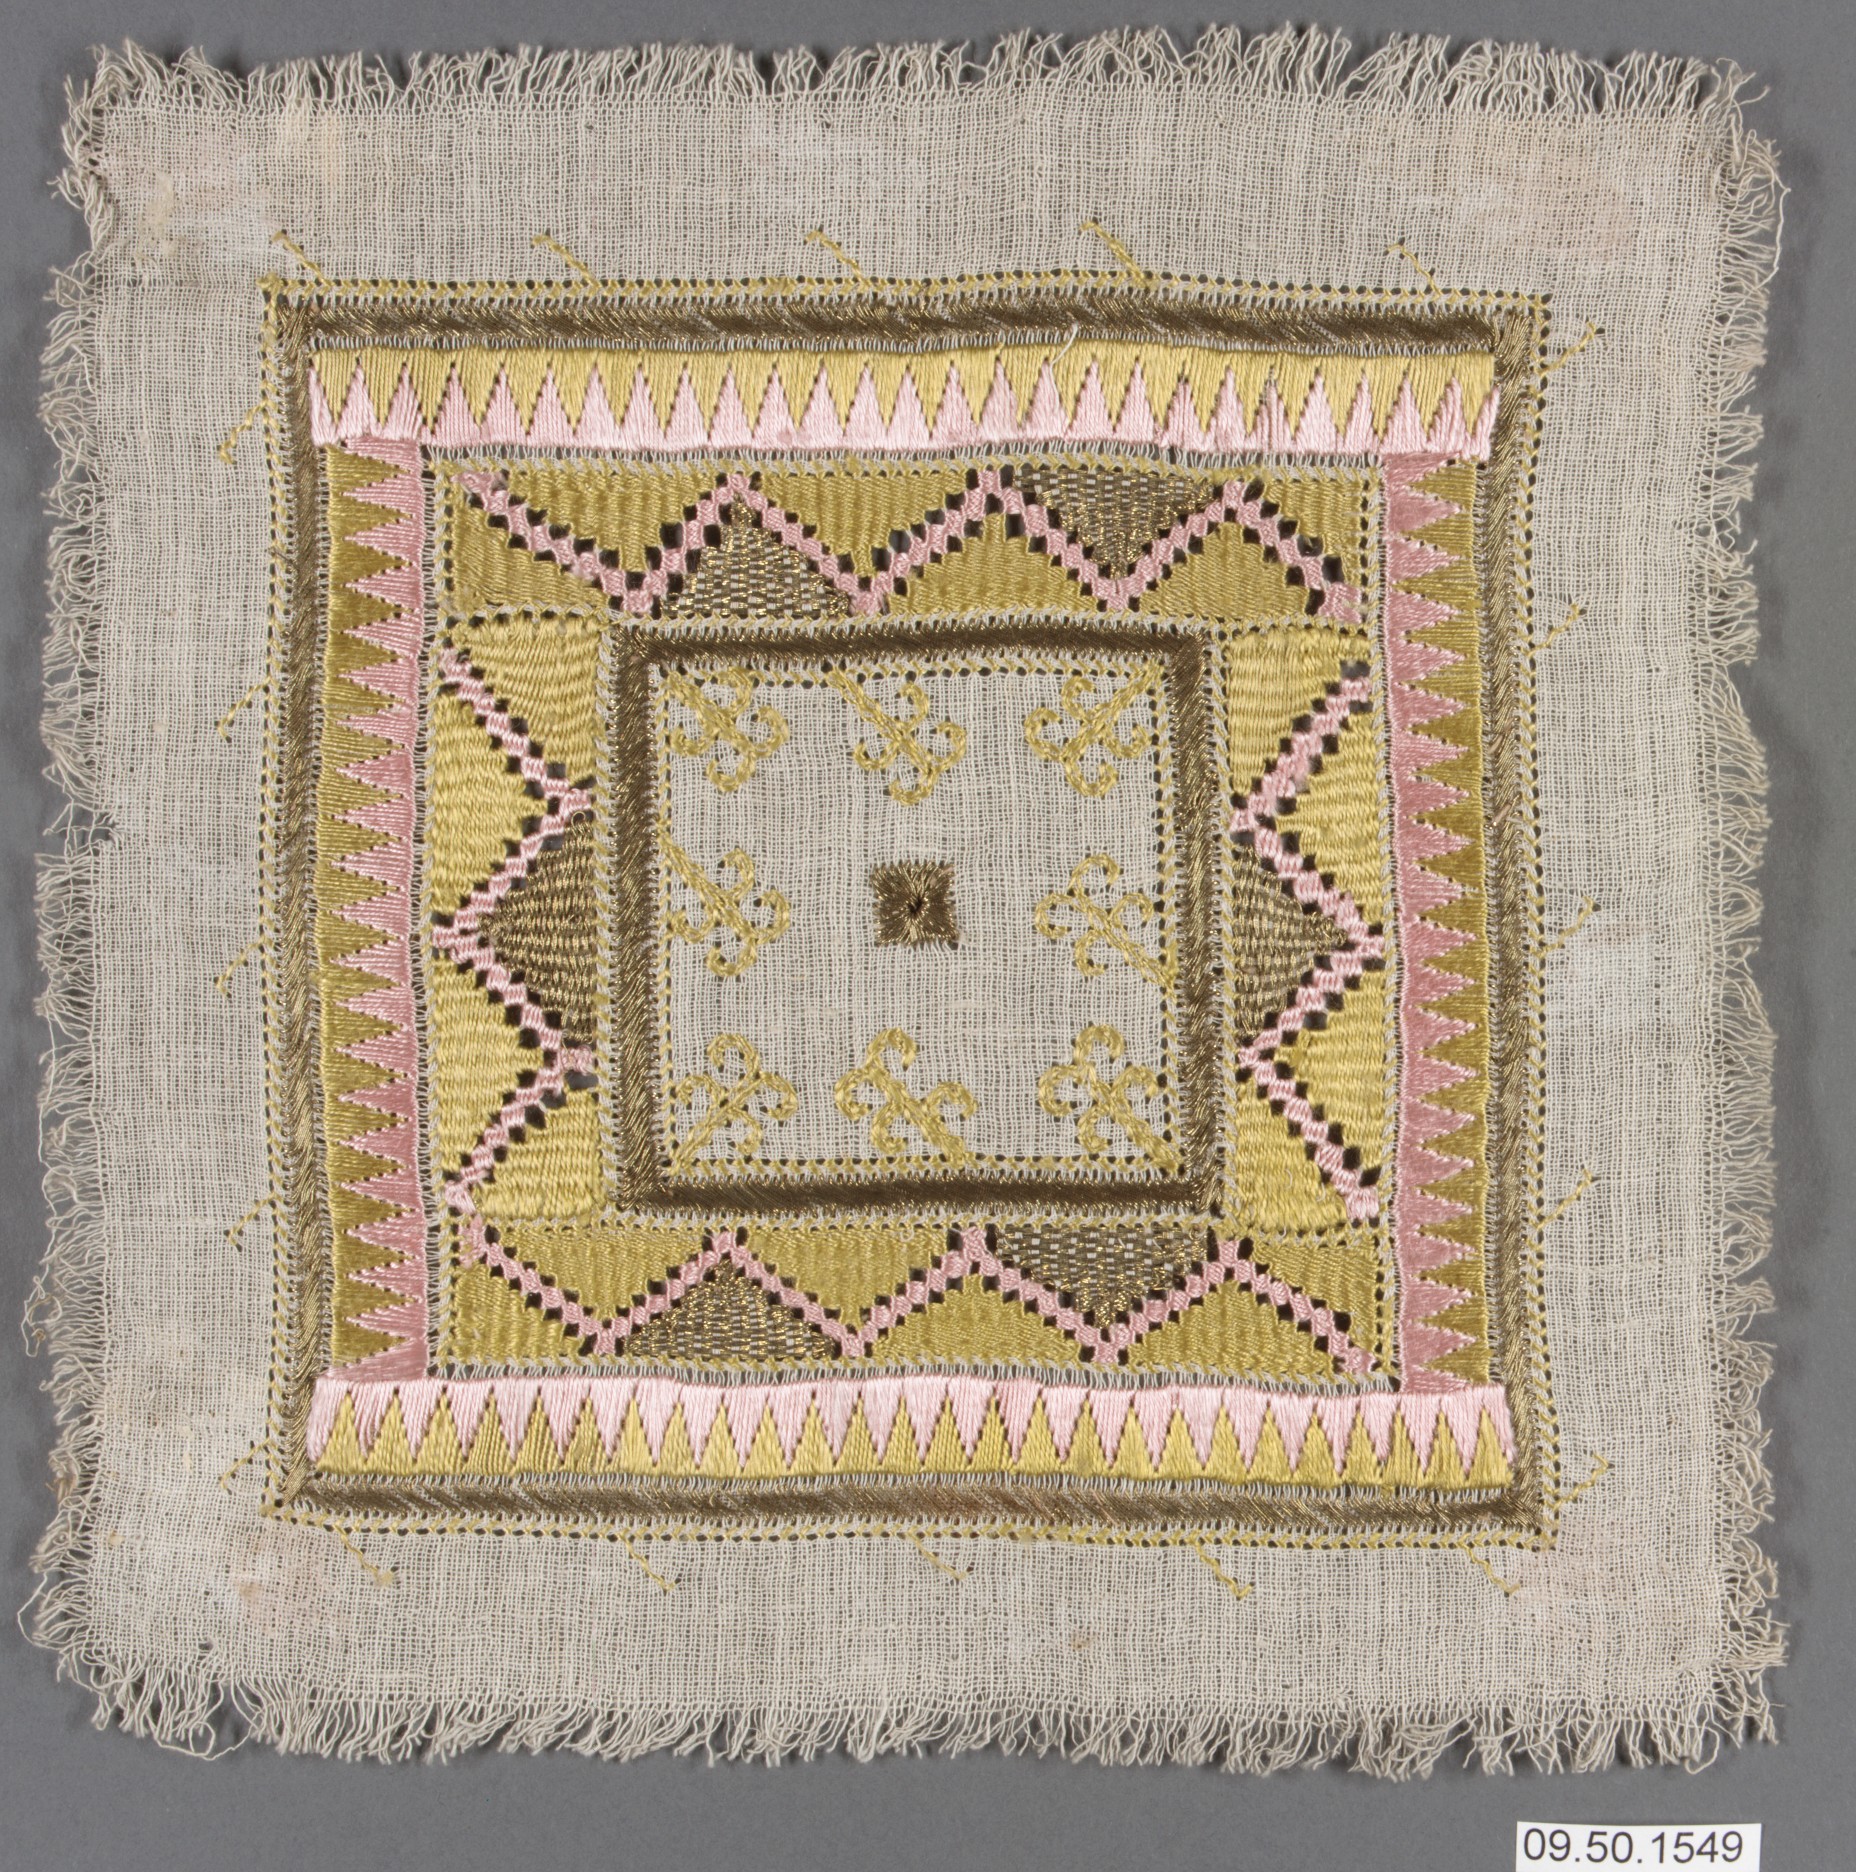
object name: square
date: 1801-1900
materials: cotton, metal thread, silk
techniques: embroidery, weave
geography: turkey